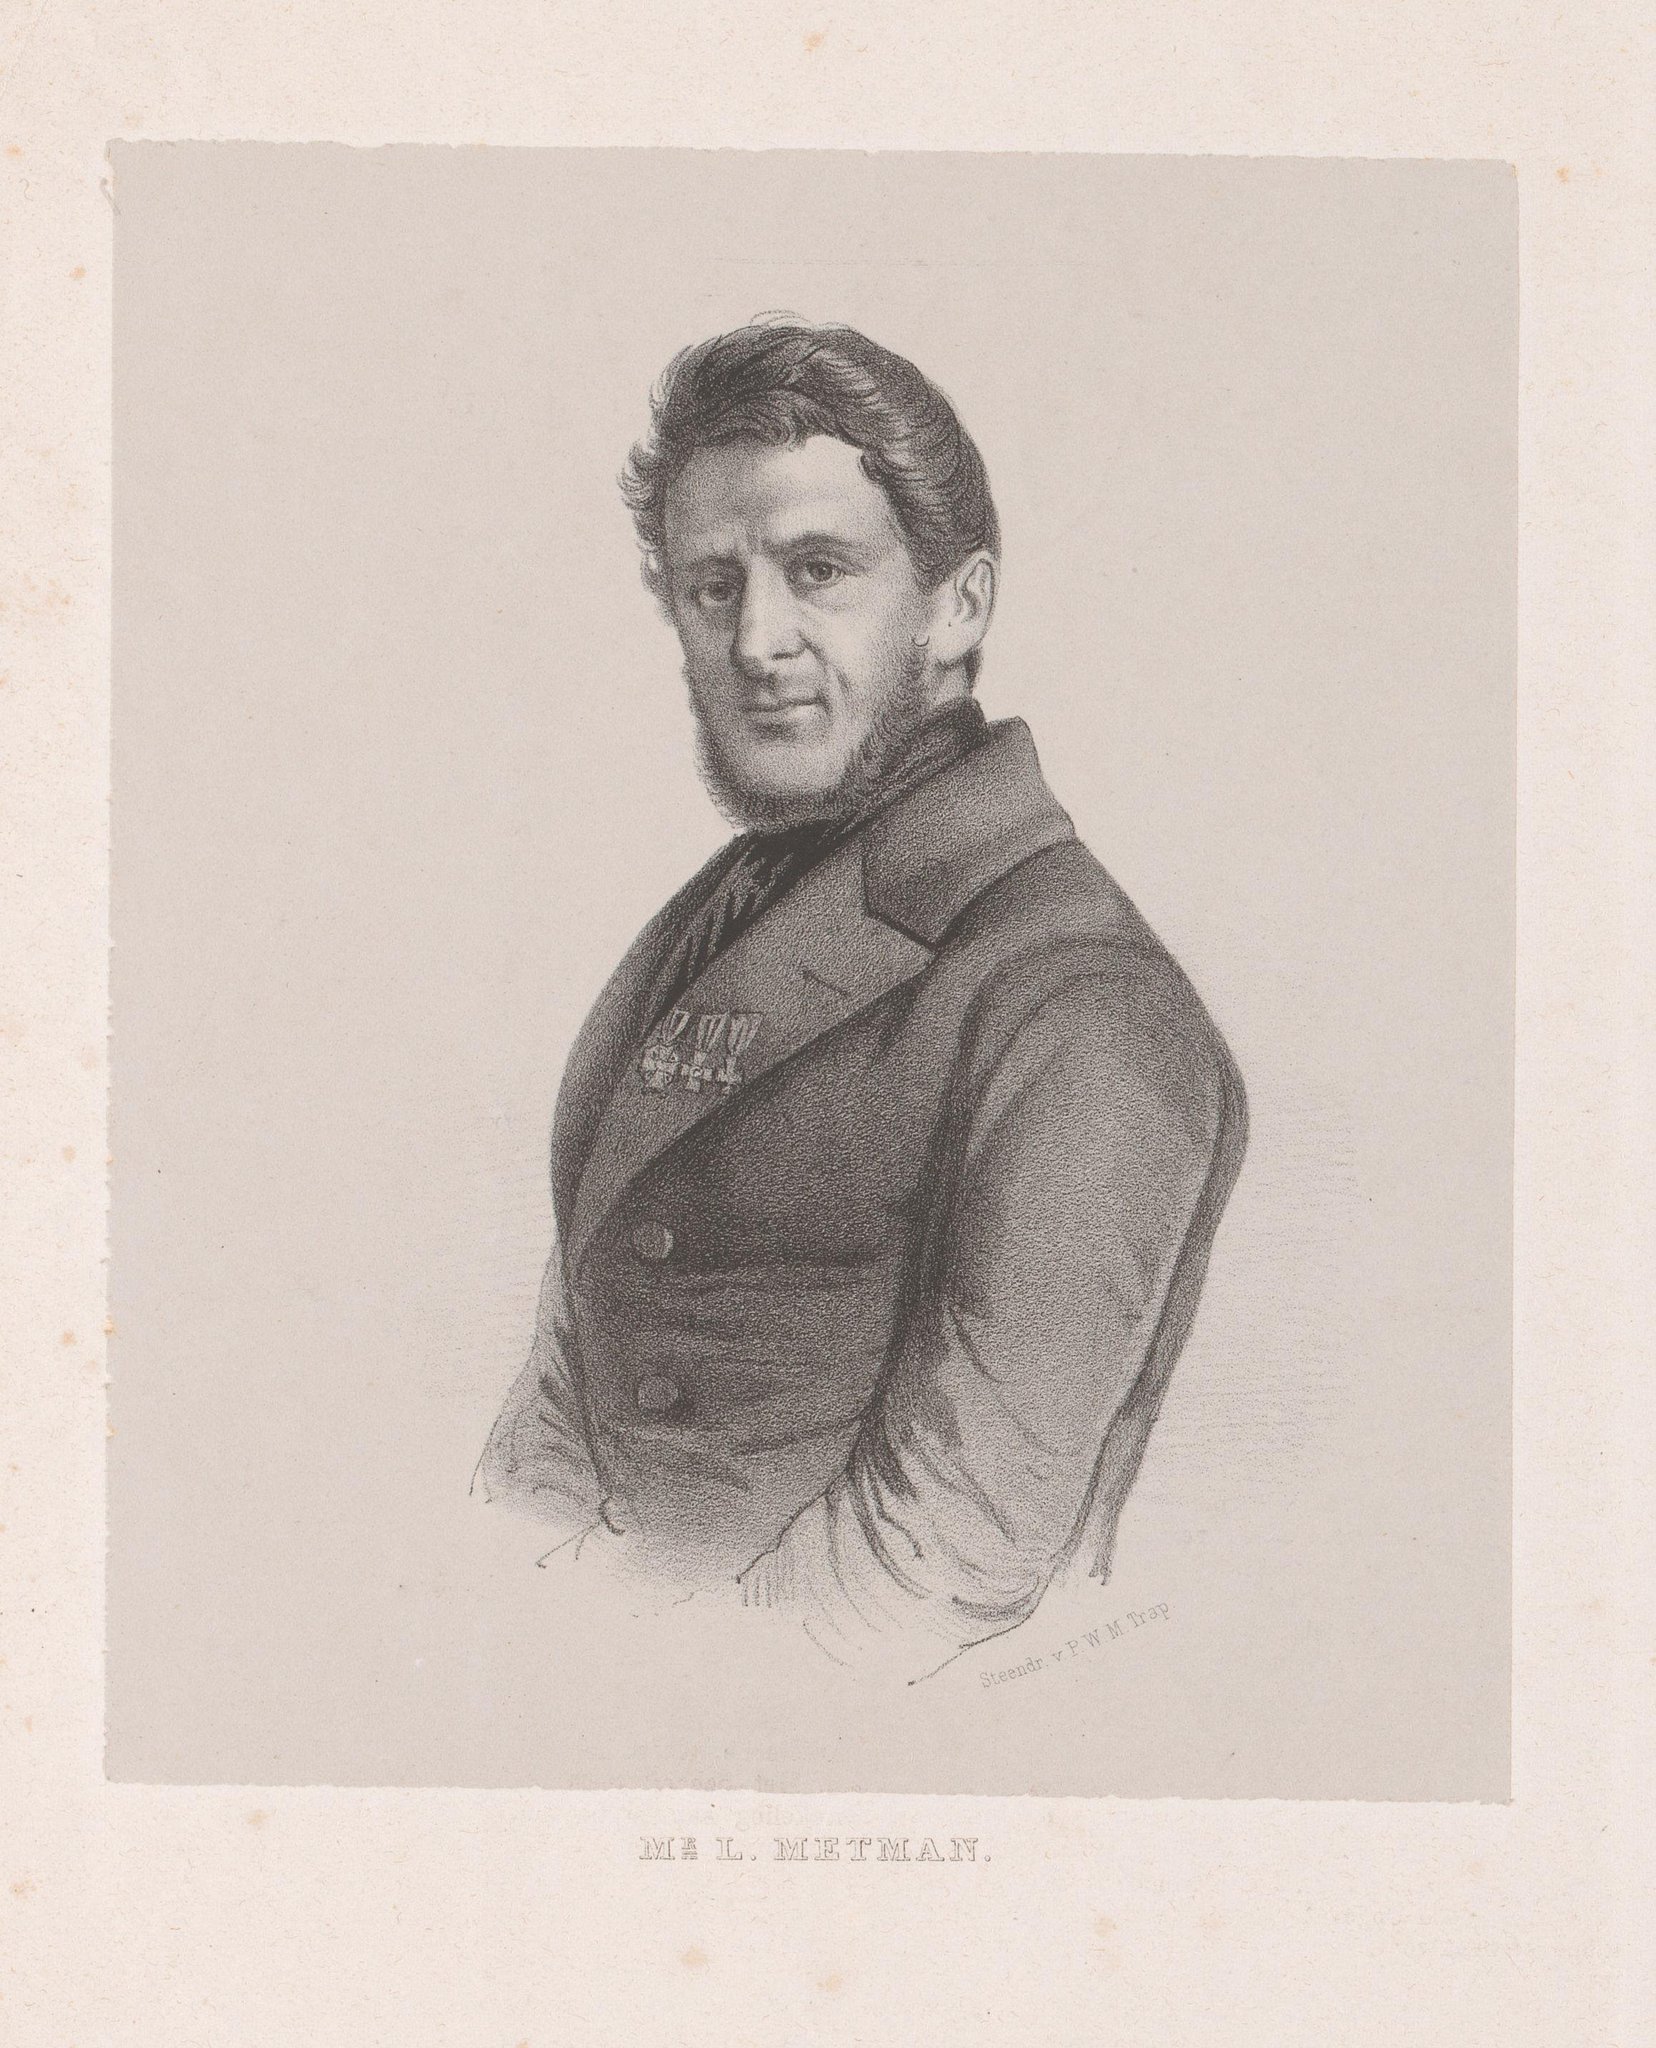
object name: print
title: Mr L. Metman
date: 1836-1905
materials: paper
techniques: lithograph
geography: leiden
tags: waalwijk, politician, historical persons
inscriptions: collector's mark: Lugt 2228